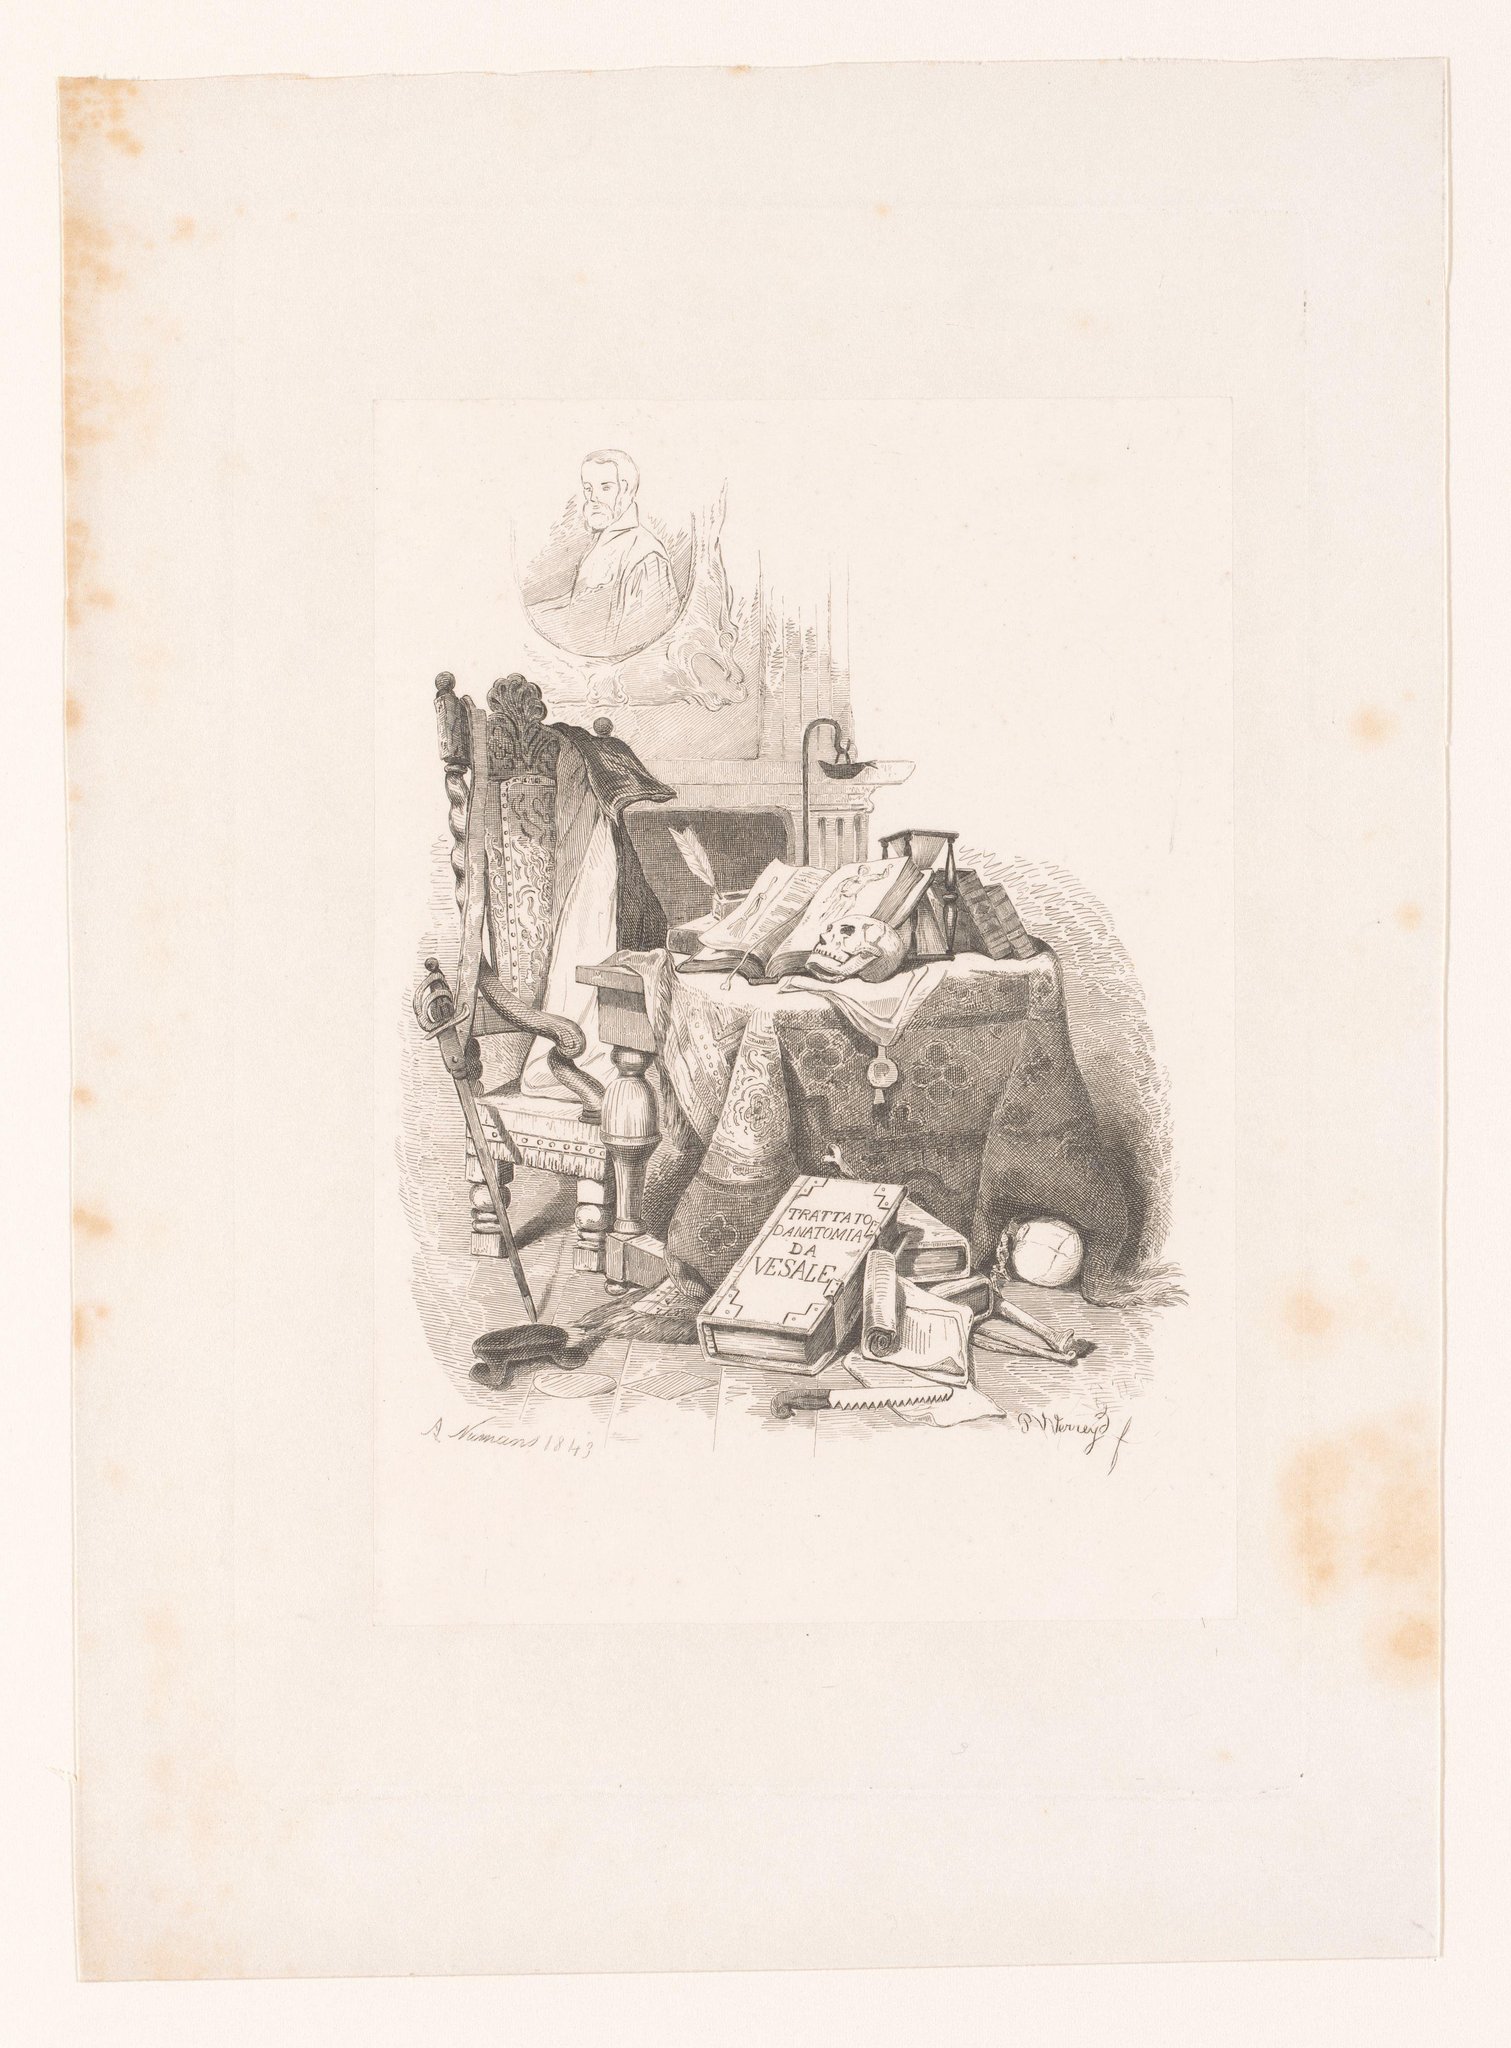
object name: print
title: Stilleven met het traktaat en een portret van Andreas Vesalius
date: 1843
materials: paper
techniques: etching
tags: brussels, some aspects of anatomy in particular, historical persons, still life of related objects, 'vanitas' still life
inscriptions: collector's mark: Lugt 2228